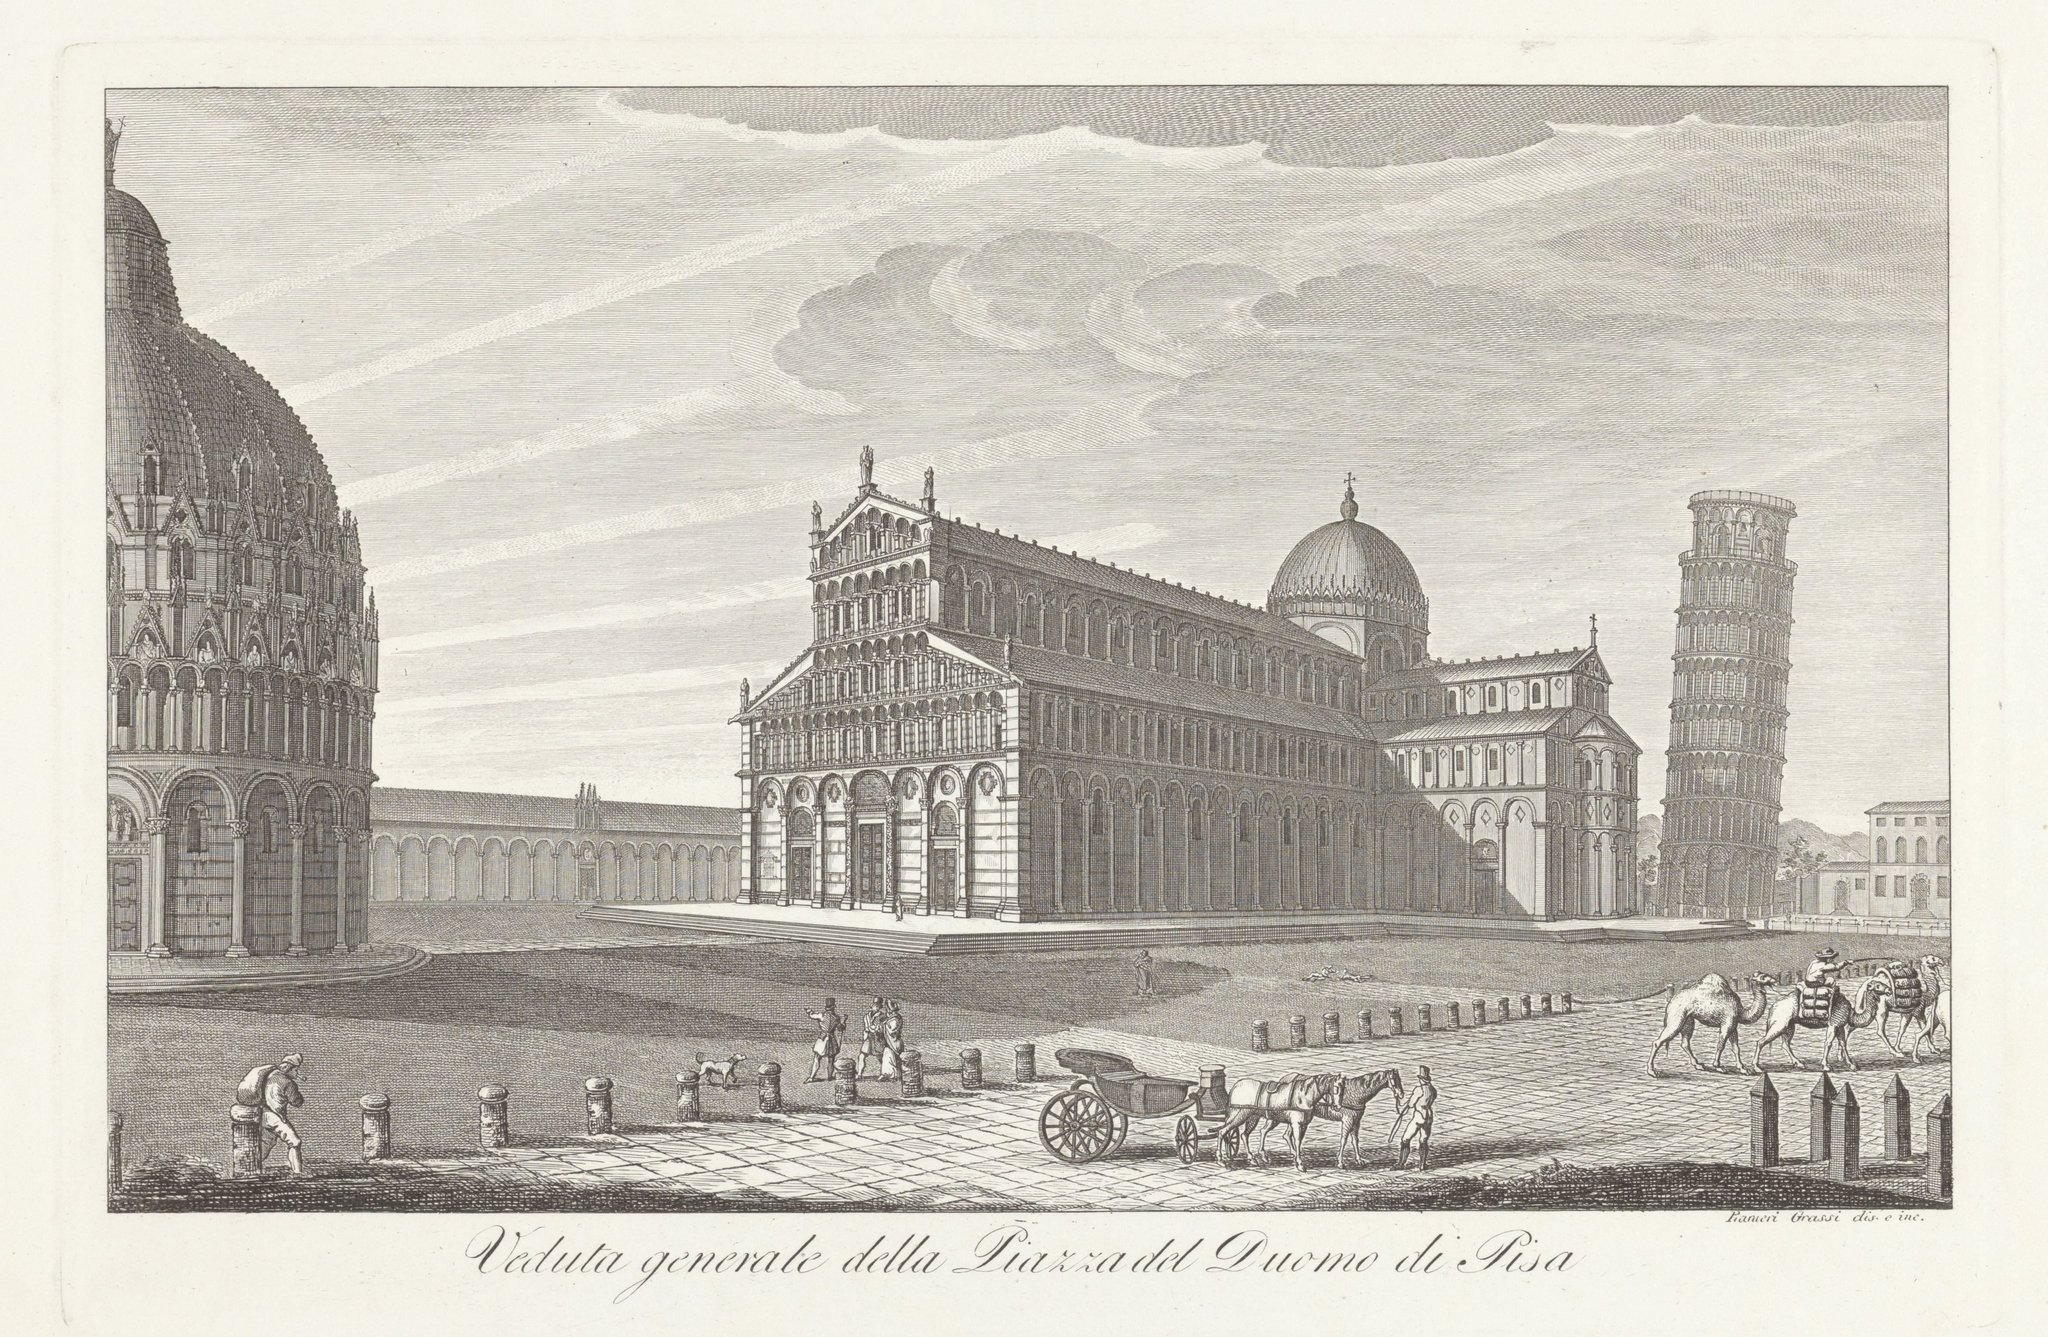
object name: print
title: Veduta generale della Piazza del Duomo di Pisa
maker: ranieri grassi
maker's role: print maker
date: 1831-1854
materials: paper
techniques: etching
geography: pisa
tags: parts of church exterior and annexes: campanile, square, place, circus, etc., city-view in general; 'veduta', church (exterior), parts of church exterior and annexes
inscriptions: collector's mark: Lugt 2228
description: Gezicht op het Piazza del Duomo in Pisa (ook wel Piazza dei Miracoli genoemd) met de Dom van Pisa (Duomo di Pisa), het Battistero di San Giovanni, het Campo Santo en de Toren van Pisa (Campanile).